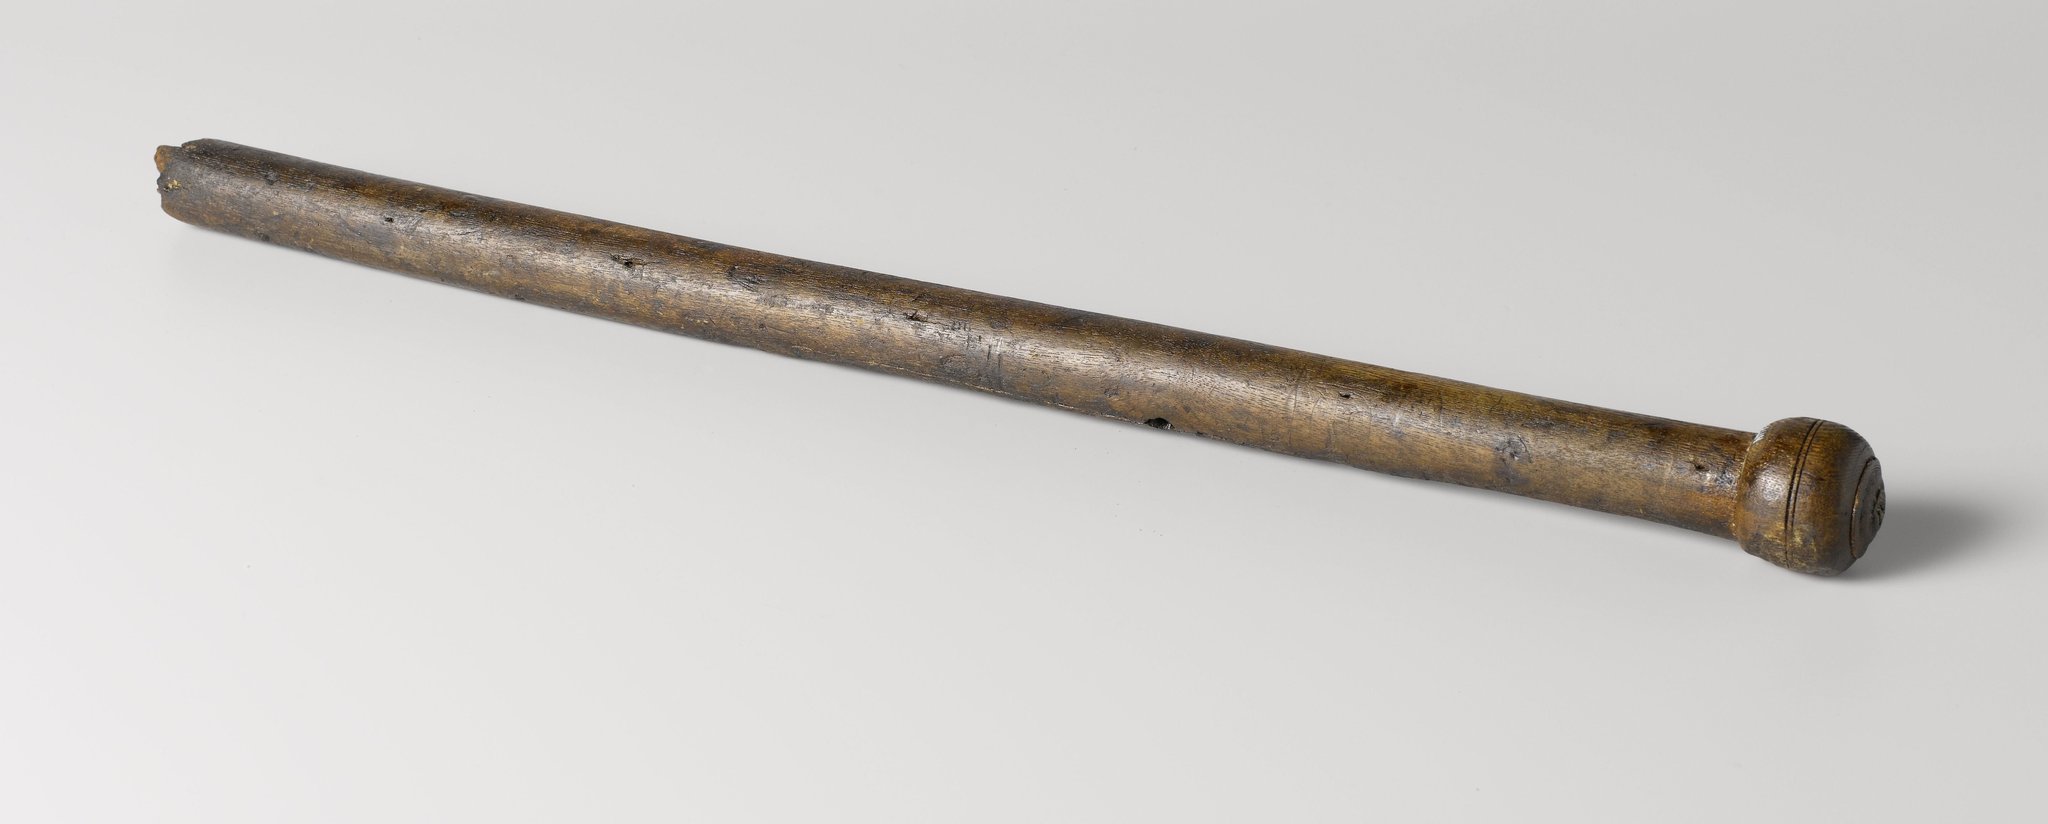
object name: stok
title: Stok van een wimpel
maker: Anonymous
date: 1590-1596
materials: wood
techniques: turning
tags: willem barendsz., amsterdam, jacob van heemskerck